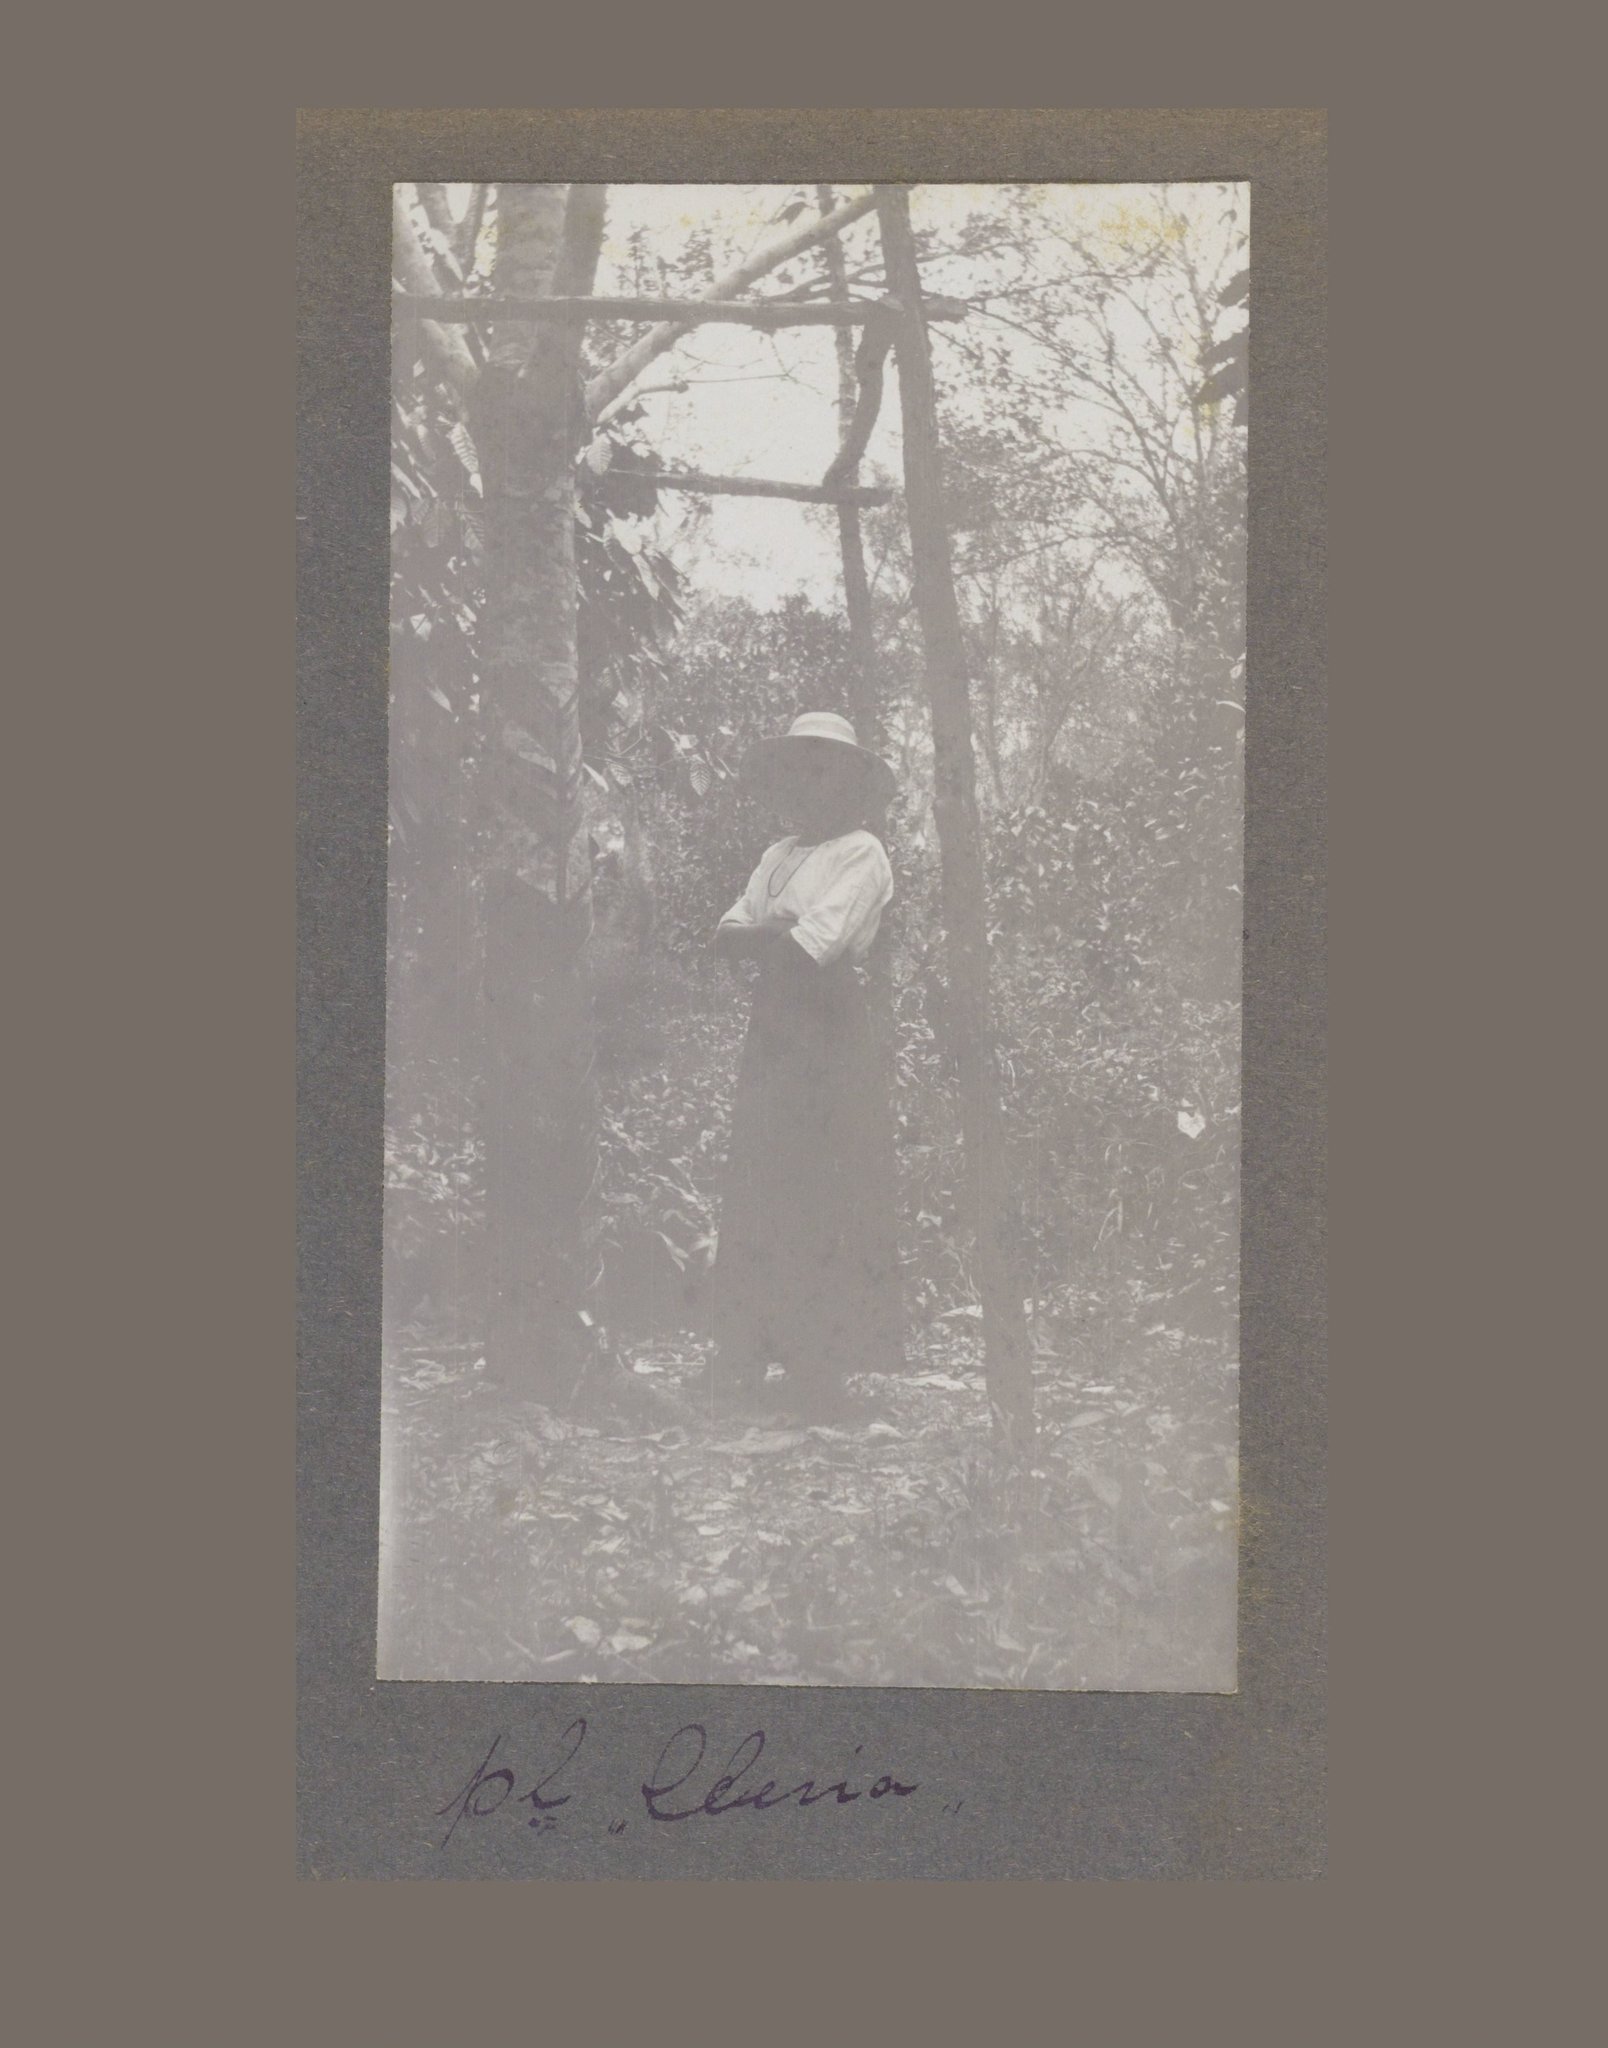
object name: photograph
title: Maria Gonggrijp, staand met hoed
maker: Anonymous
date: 1912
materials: photographic support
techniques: photography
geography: suriname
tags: suriname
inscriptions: inscription: ‘pl. Clevia’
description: Maria Gonggrijp staand tussen bomen, met een grote zonnehoed op het hoofd. Op Plantage Clevia. Onderdeel van het fotoalbum over het leven van de familie Gonggrijp in Suriname rond 1912.